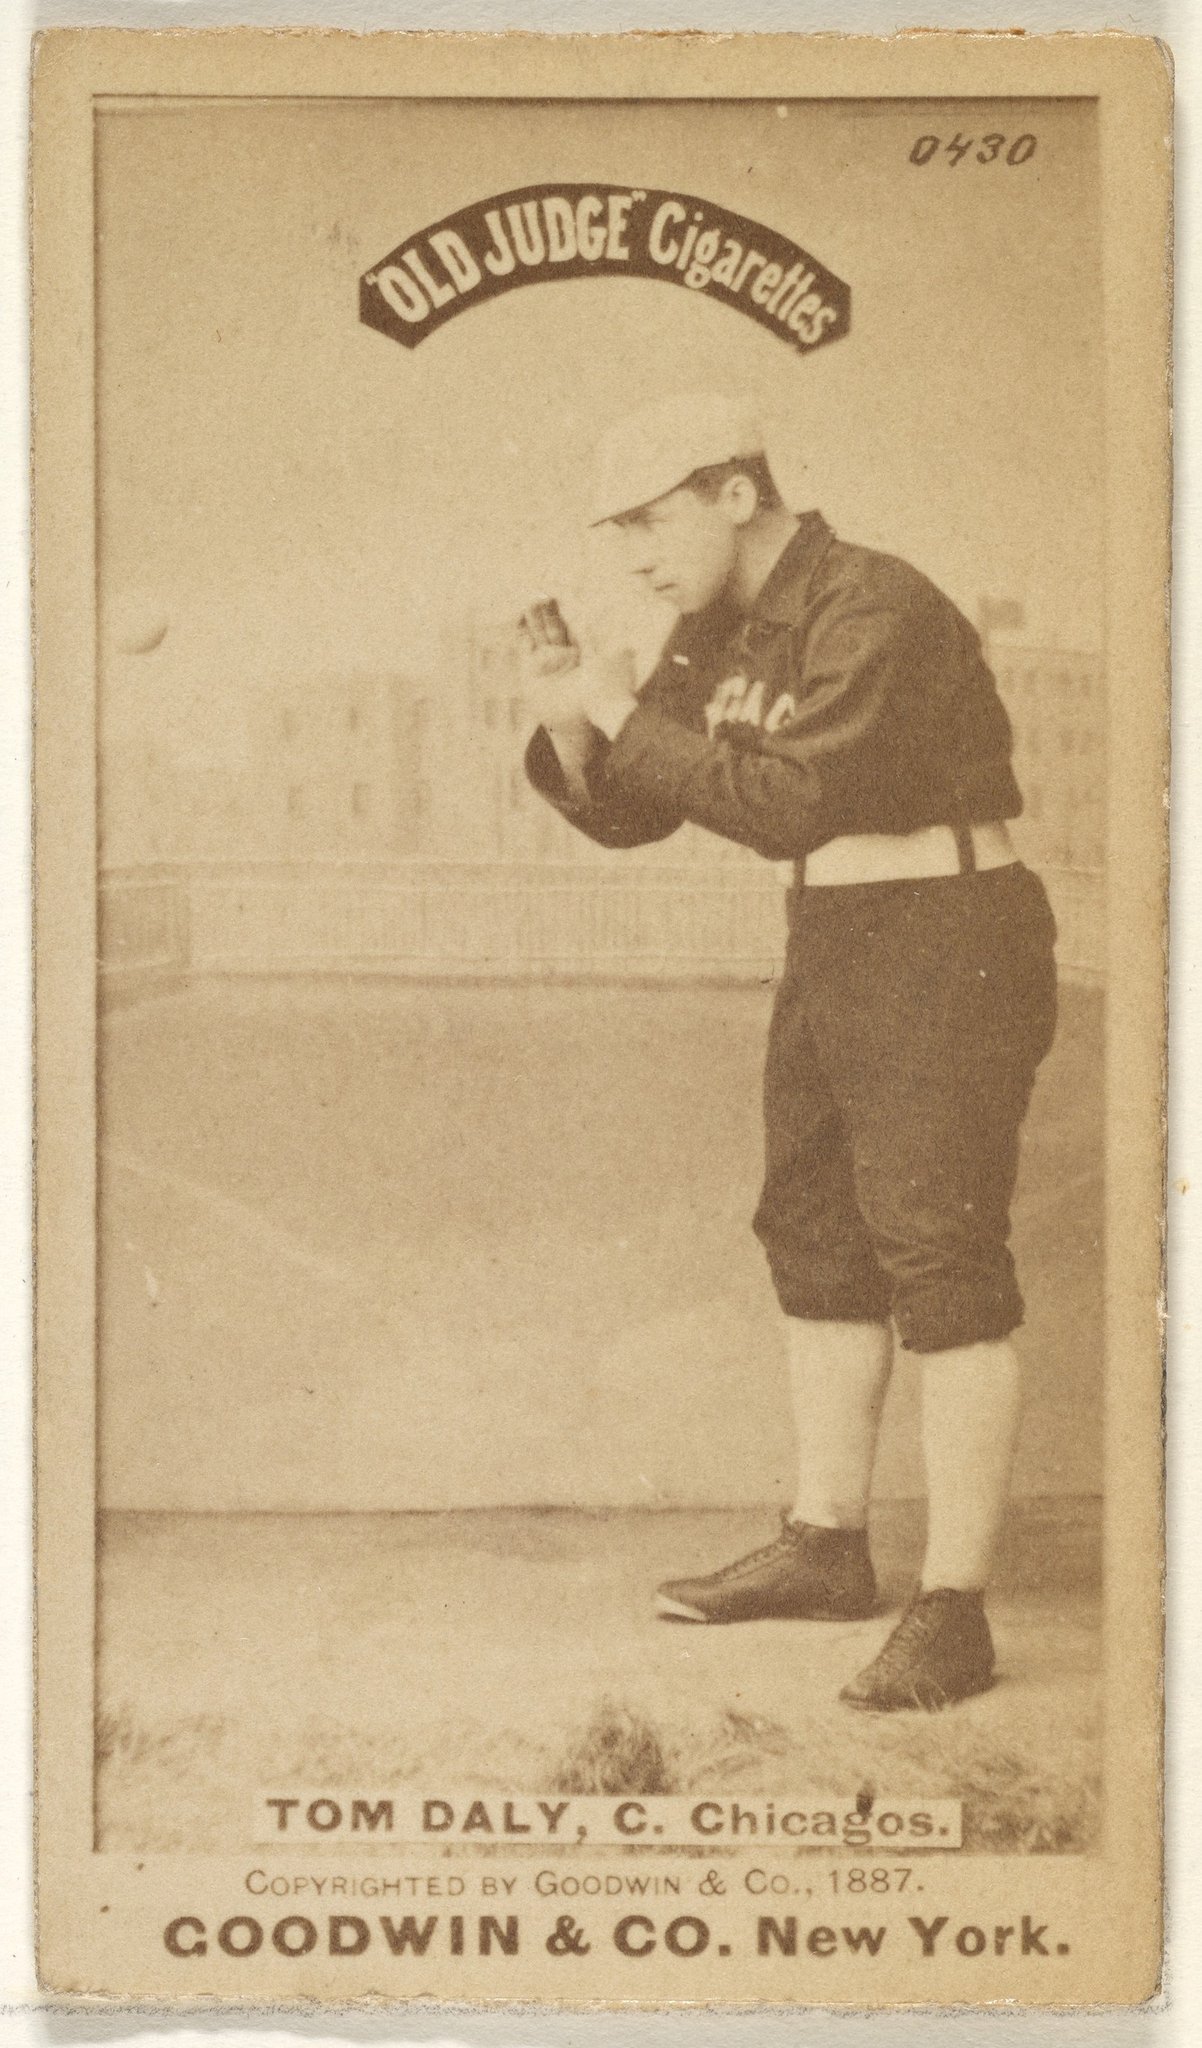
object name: baseball card, photograph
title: Tom Daly, Catcher, Chicago, from the Old Judge series (N172) for Old Judge Cigarettes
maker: goodwin & company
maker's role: publisher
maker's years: 1850-1950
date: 1887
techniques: albumen silver print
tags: men,portraits,baseball,athletes